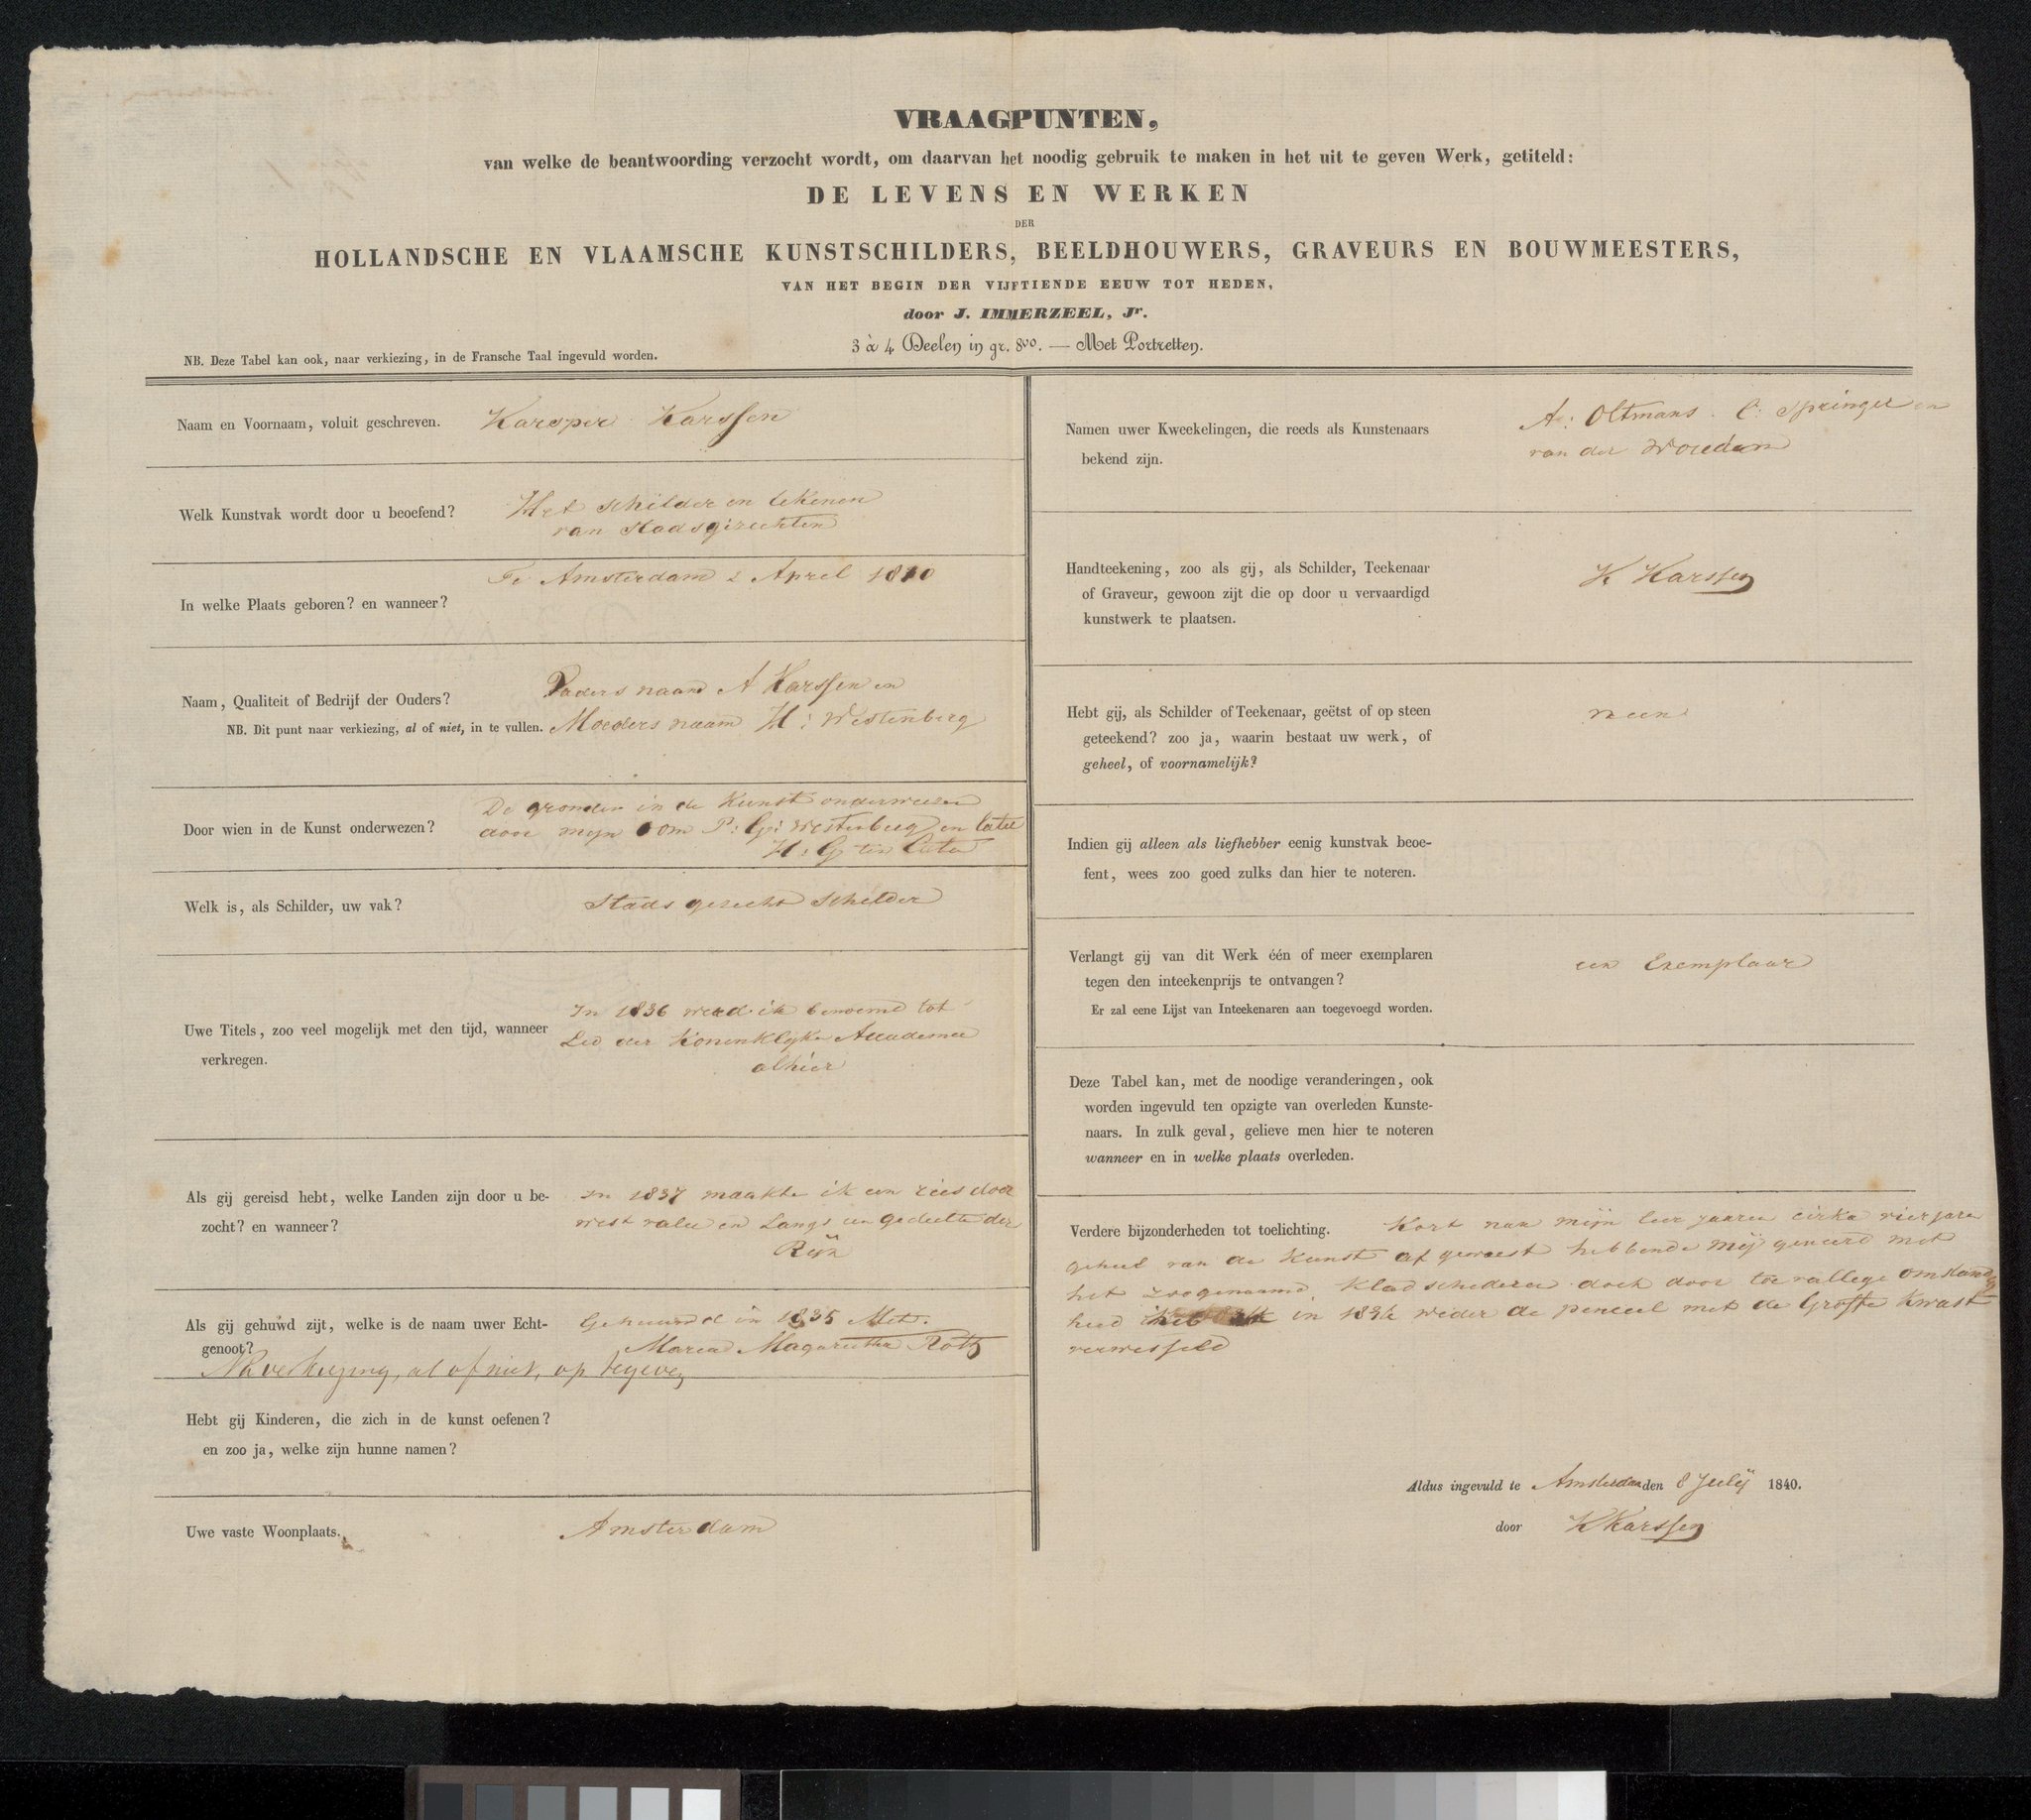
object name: questionnaire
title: Enquêteformulier ingevuld door Kasparus Karsen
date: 1840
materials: ink, paper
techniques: pen, printing, writing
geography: amsterdam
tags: painter, draughtsman, kasparus karsen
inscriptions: watermark, inscription: ‘Vraagpunten,/ van welke de beantwoording verzocht wordt, om daarvan het noodig gebruik te maken in het uit te geven Werk, getiteld: De levens en werken/ der Hollandsche en Vlaamsche kunstschilders, beeldhouwers,/ graveurs en bouwmeesters, van het begin der vijftiende eeuw tot heden/ door J. Immerzeel, Jr.’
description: Opgenomen in: Immerzeel, J. Jr., De levens en werken der Hollandsche en Vlaamsche kunstschilders, beeldhouwers, graveurs en bouwmeesters, van het begin der vijftiende eeuw tot heden, Amsterdam: J.C. van Kesteren, 1842-1843.